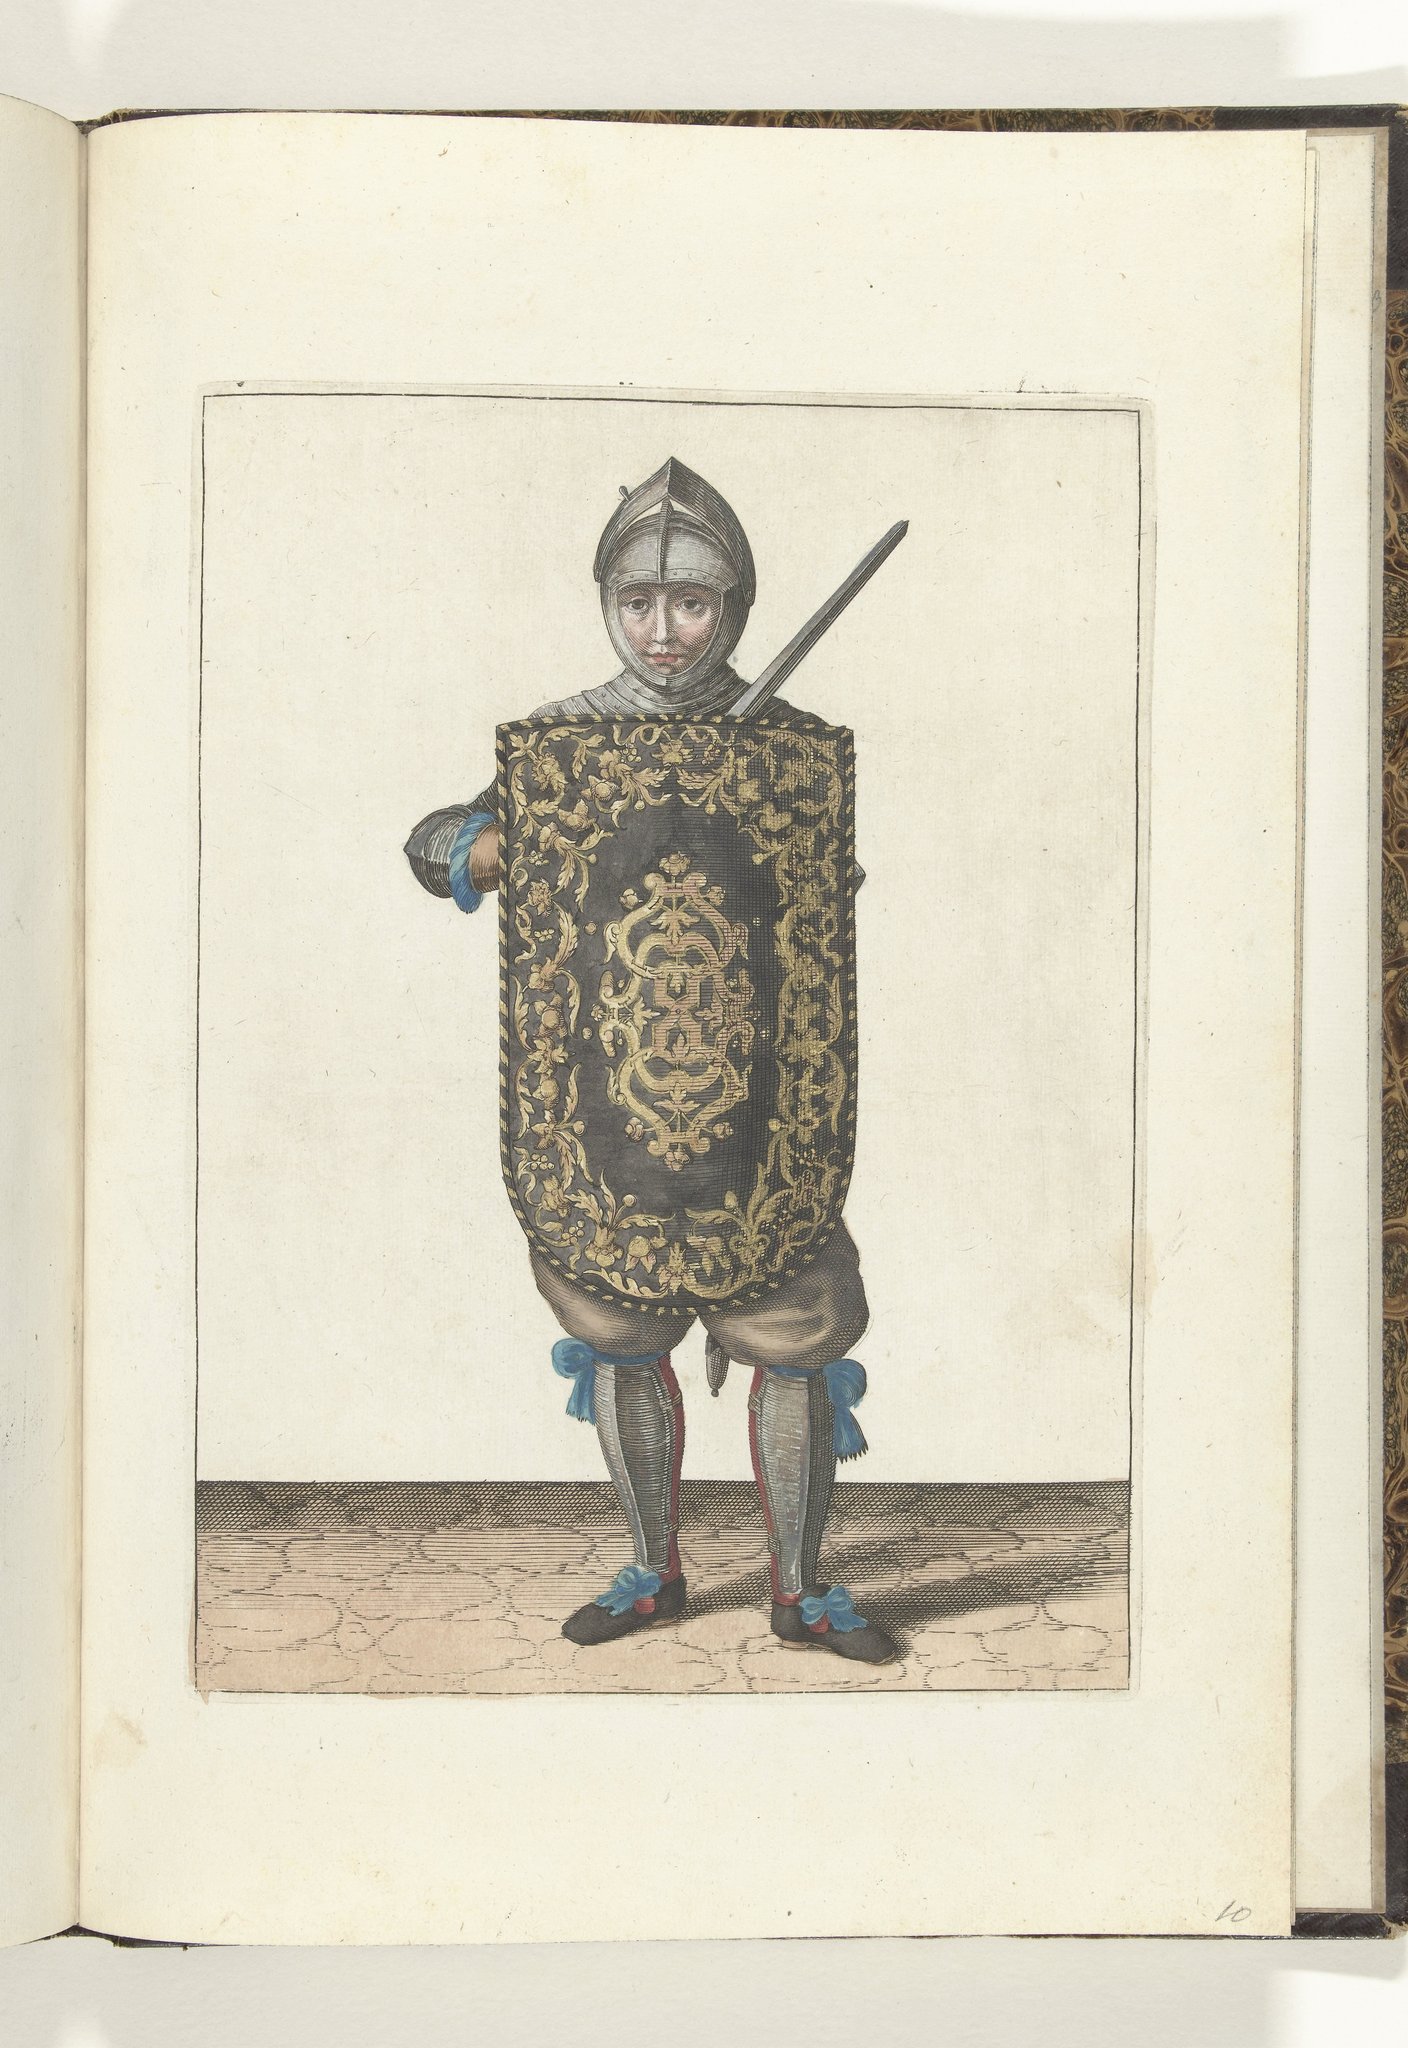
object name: print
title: De exercitie met de targe en rapier: de soldaat richt zich weer op en neemt de positie in met rapier en targe voor de borst en vizier open, (nr. 10), 1618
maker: Anonymous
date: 1616-1618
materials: paper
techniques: engraving, hand coloring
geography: northern netherlands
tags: the hague, maurice (prince of orange), handling of weapons ~ military training, weapons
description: Illustratie in: Adam van Breen, Nassauische Waffenhandelung / Kurtzer Bericht unnd Ahnzeigungh auff die Ab-bildungh der Figuren / den rechten brauch alles des jenigen betreffend / so einem Soldaten von nöten / in der handlung der Targa, met dem Degen [incompleet exemplaar], 1618?, plaat 10. Dit is een Duitse editie van Adam van Breens De Nassausche Wapen-Handelinge, van Schilt, Spies, Rappier ende Targe : beyde figuerlick afgebeelt, ende gestelt na de nieu ordening [van] ... Maurits van Nassau, 's-Gravenhage, [Aert Meuris] 1618. In het exemplaar in de collectie van de Rijksmuseum Research Library (326 F 23).